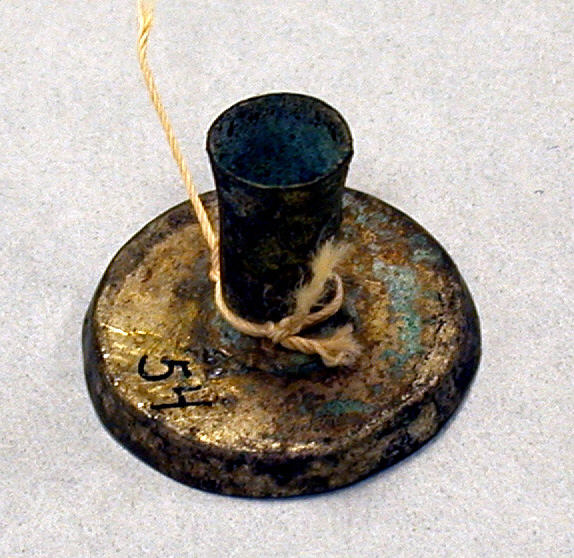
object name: ornament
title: Ornament Base (?)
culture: chancay or chimú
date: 1001-1500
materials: gilt, silver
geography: peru